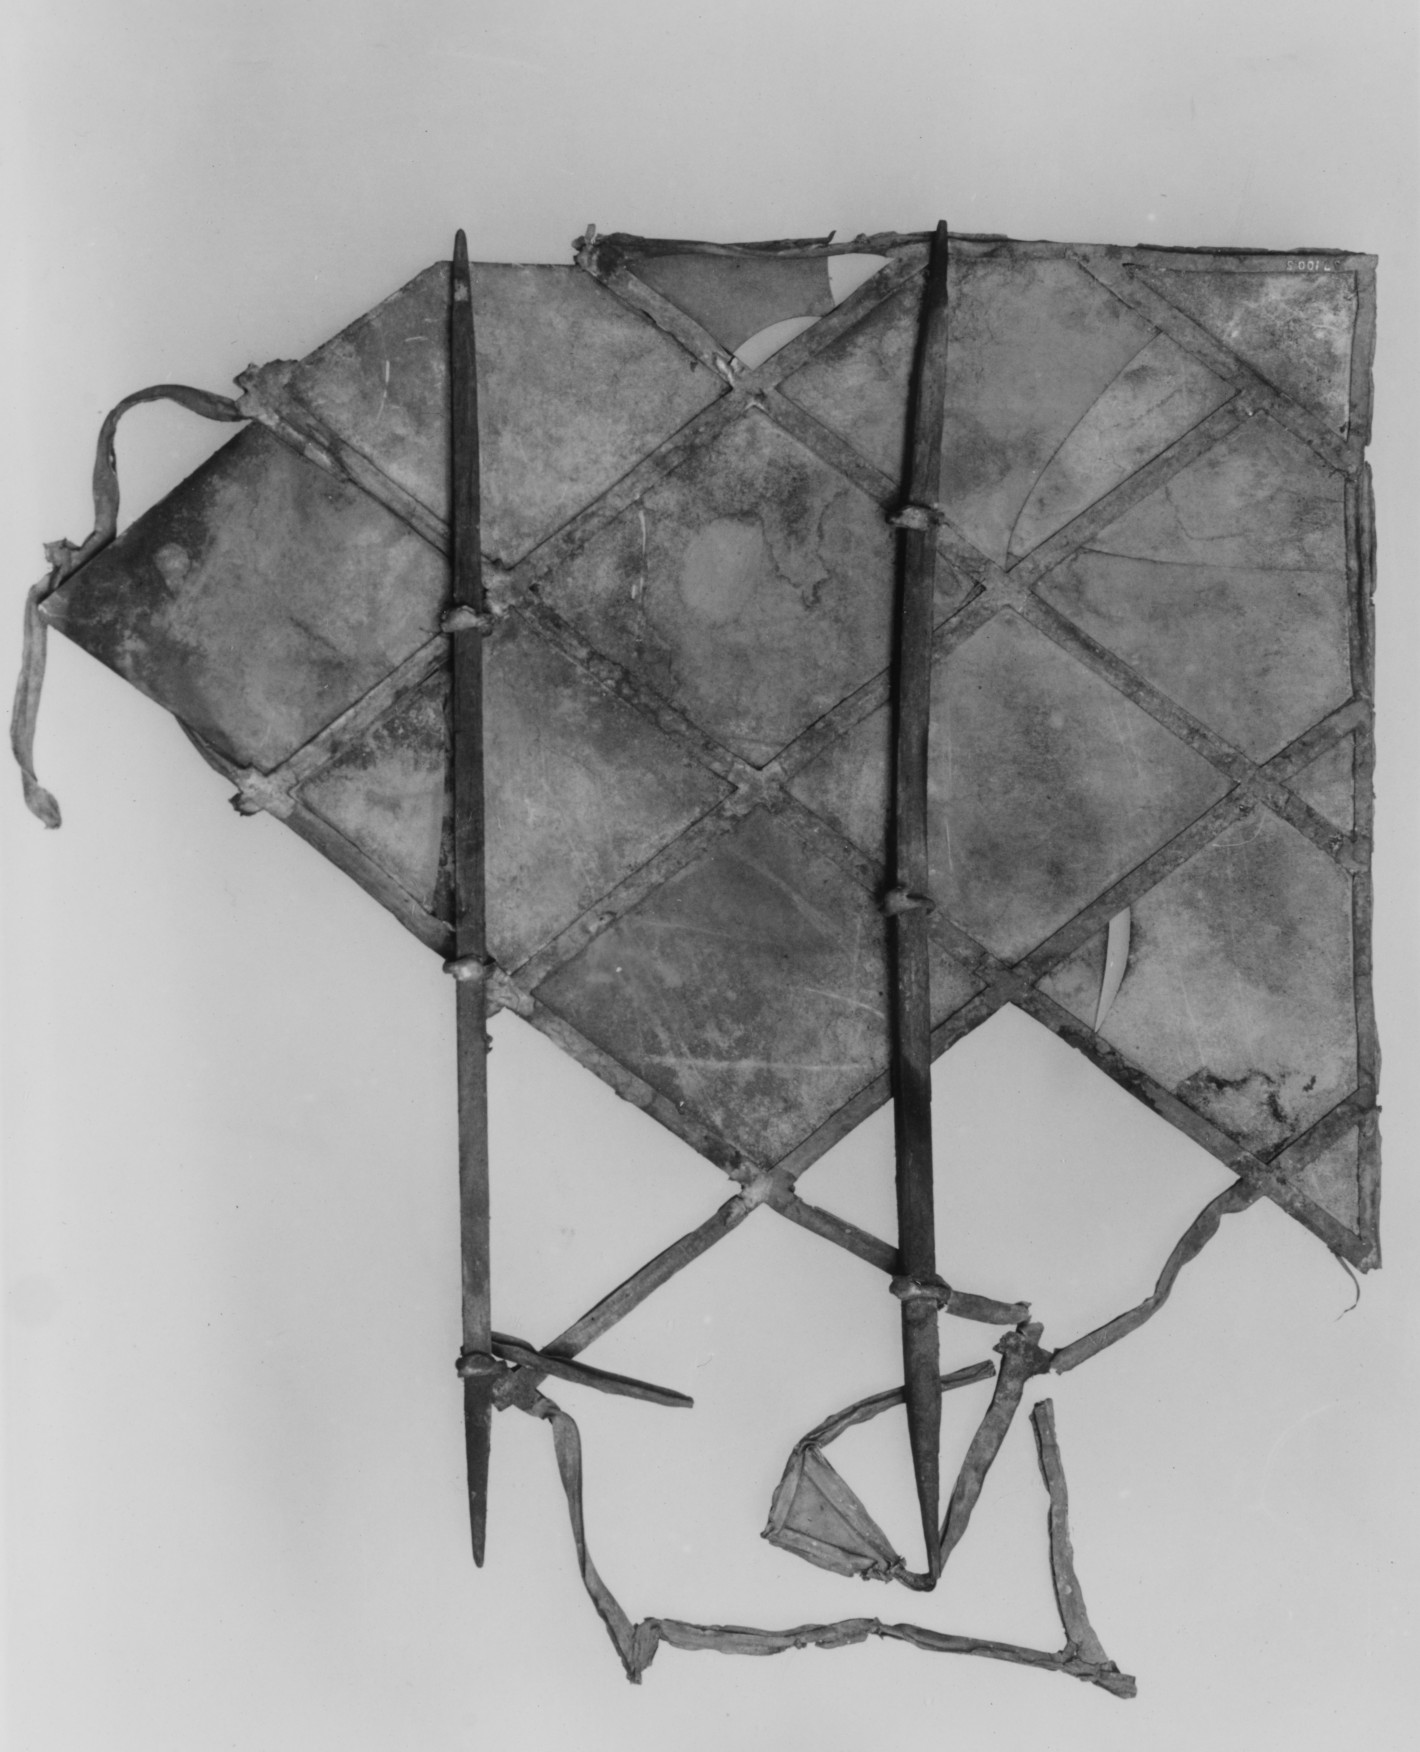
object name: casement window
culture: american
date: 1600-1700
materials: glass, lead, wood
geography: united states